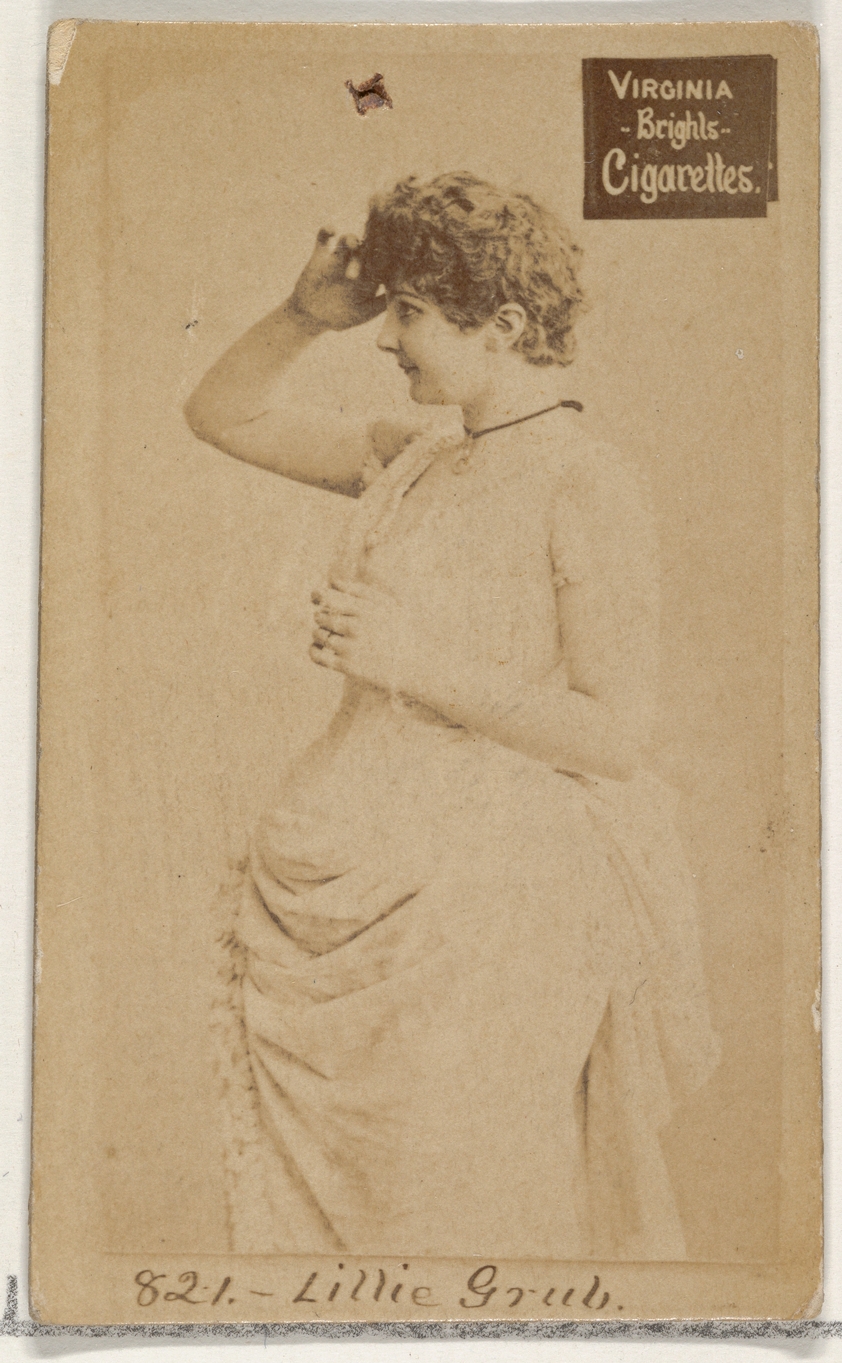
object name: photograph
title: Card 821, Lillie Grub, from the Actors and Actresses series (N45, Type 2) for Virginia Brights Cigarettes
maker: allen & ginter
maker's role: publisher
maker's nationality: american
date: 1888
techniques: albumen silver print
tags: portraits,women,actresses